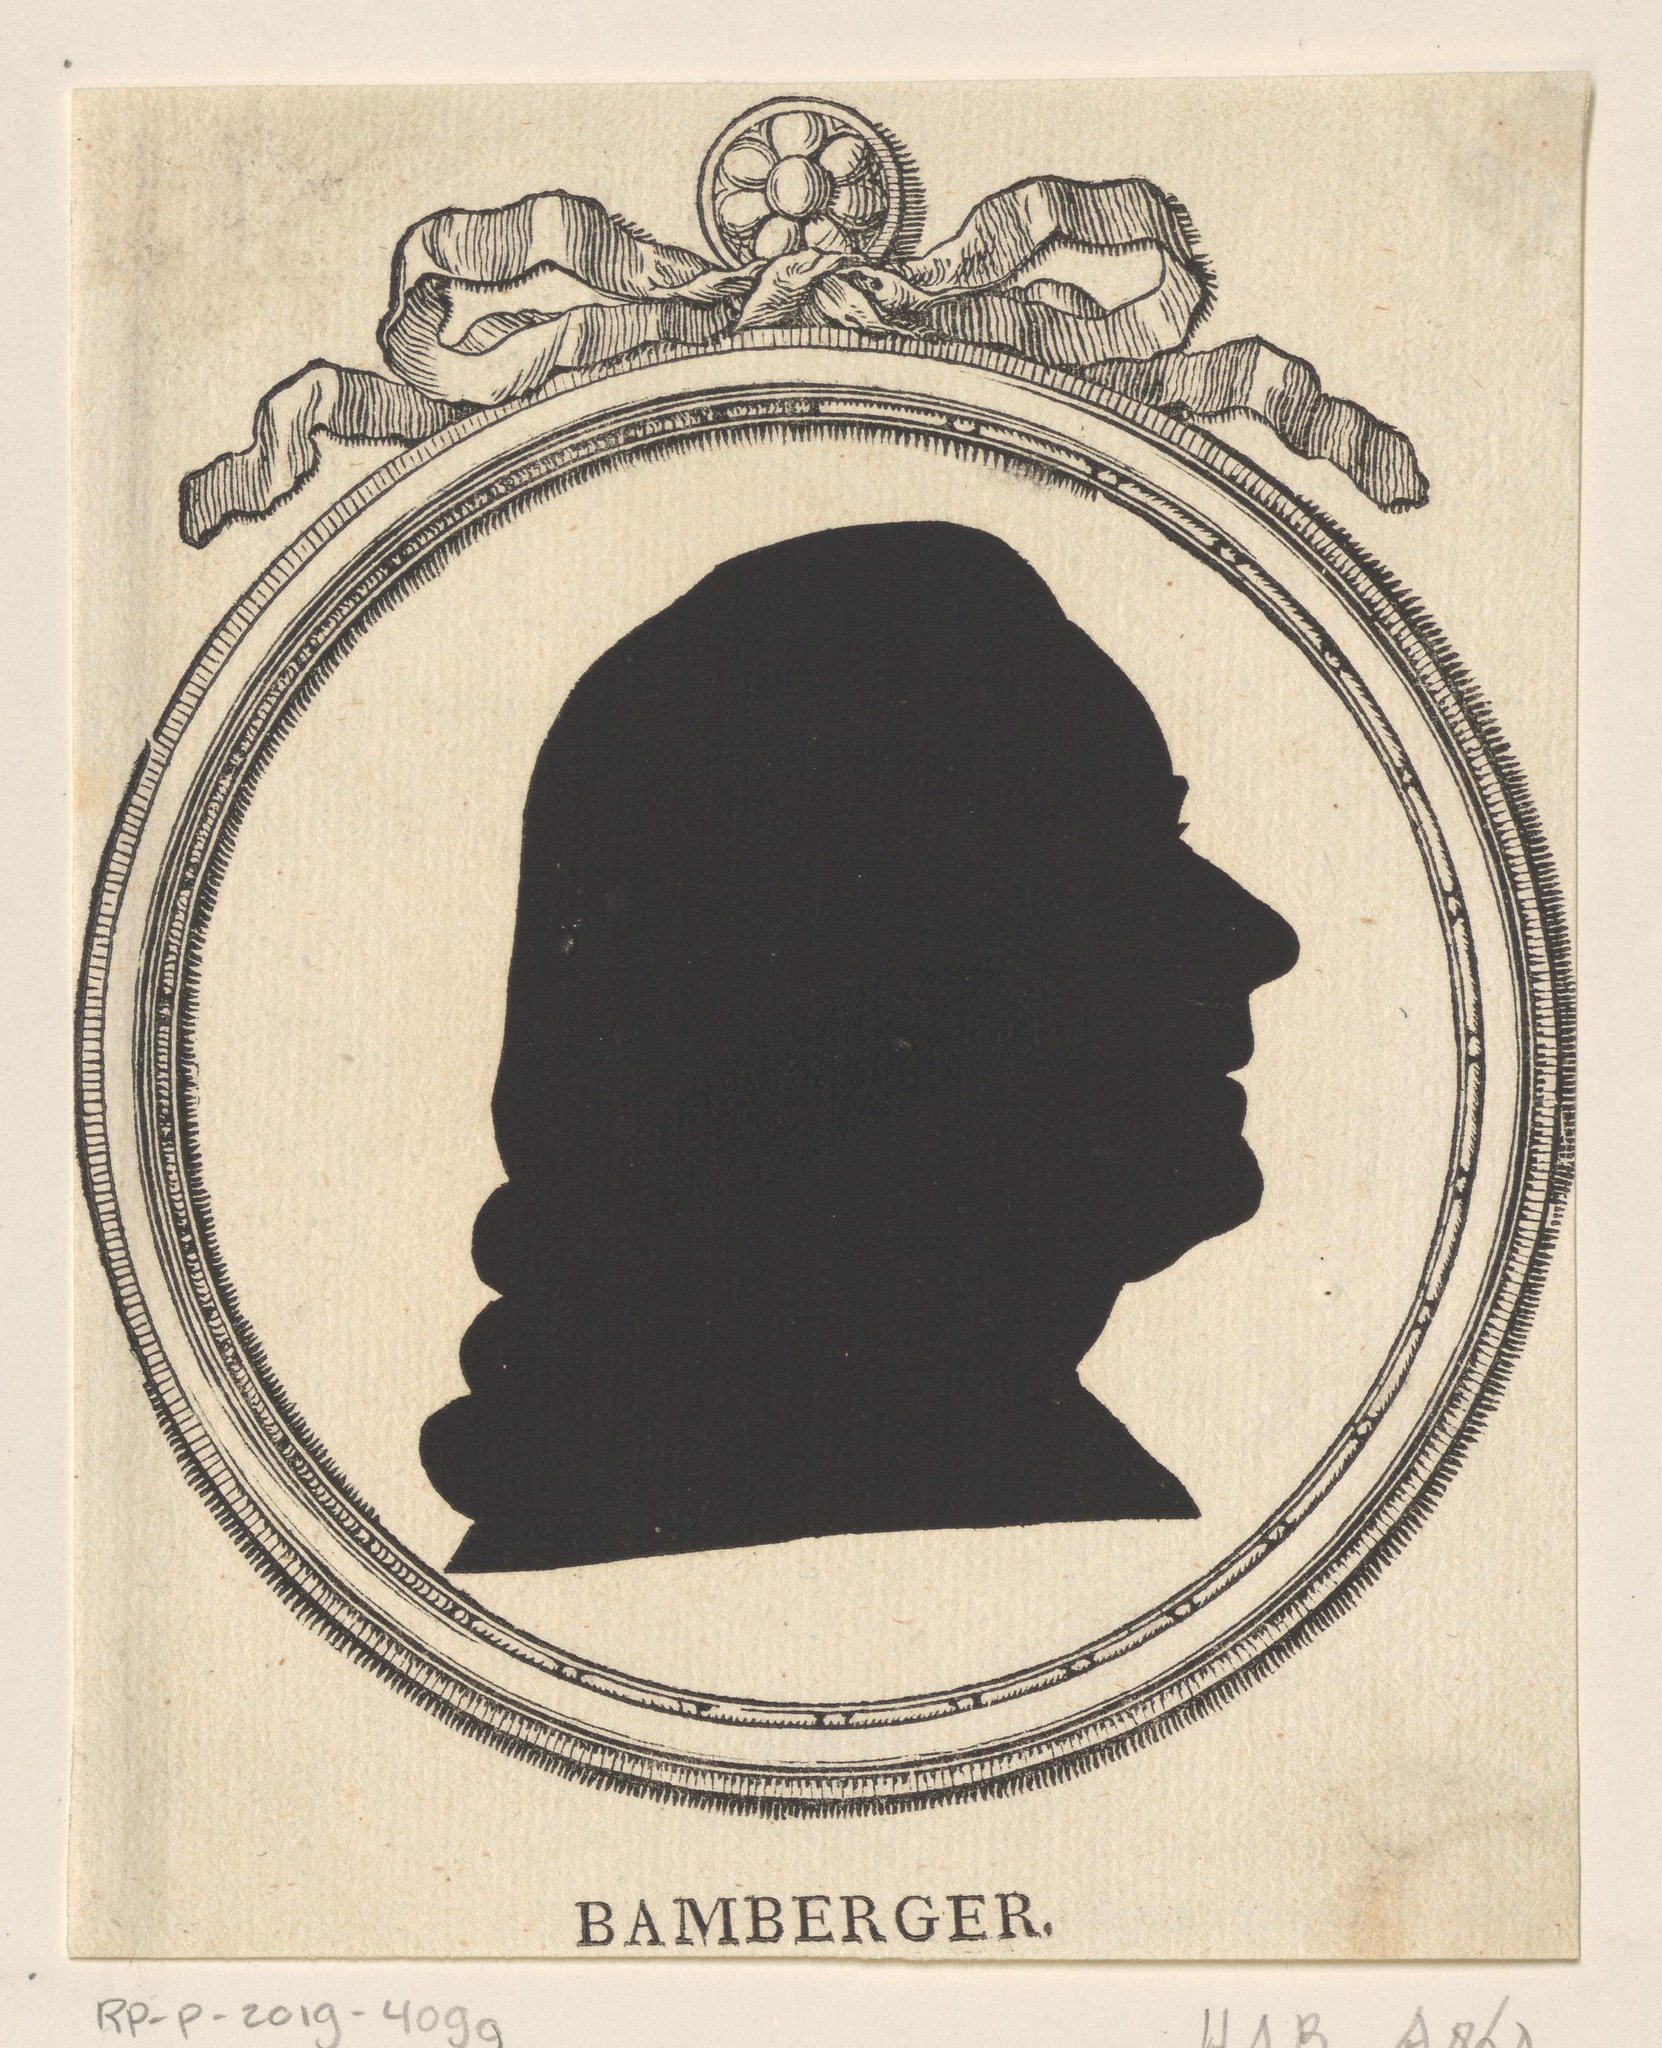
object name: print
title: Silhouetportret van Johann Peter Bamberger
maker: johann friedrich gottlieb unger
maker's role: print maker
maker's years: 1753-1804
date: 1763-1804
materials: paper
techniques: letterpress printing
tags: historical persons